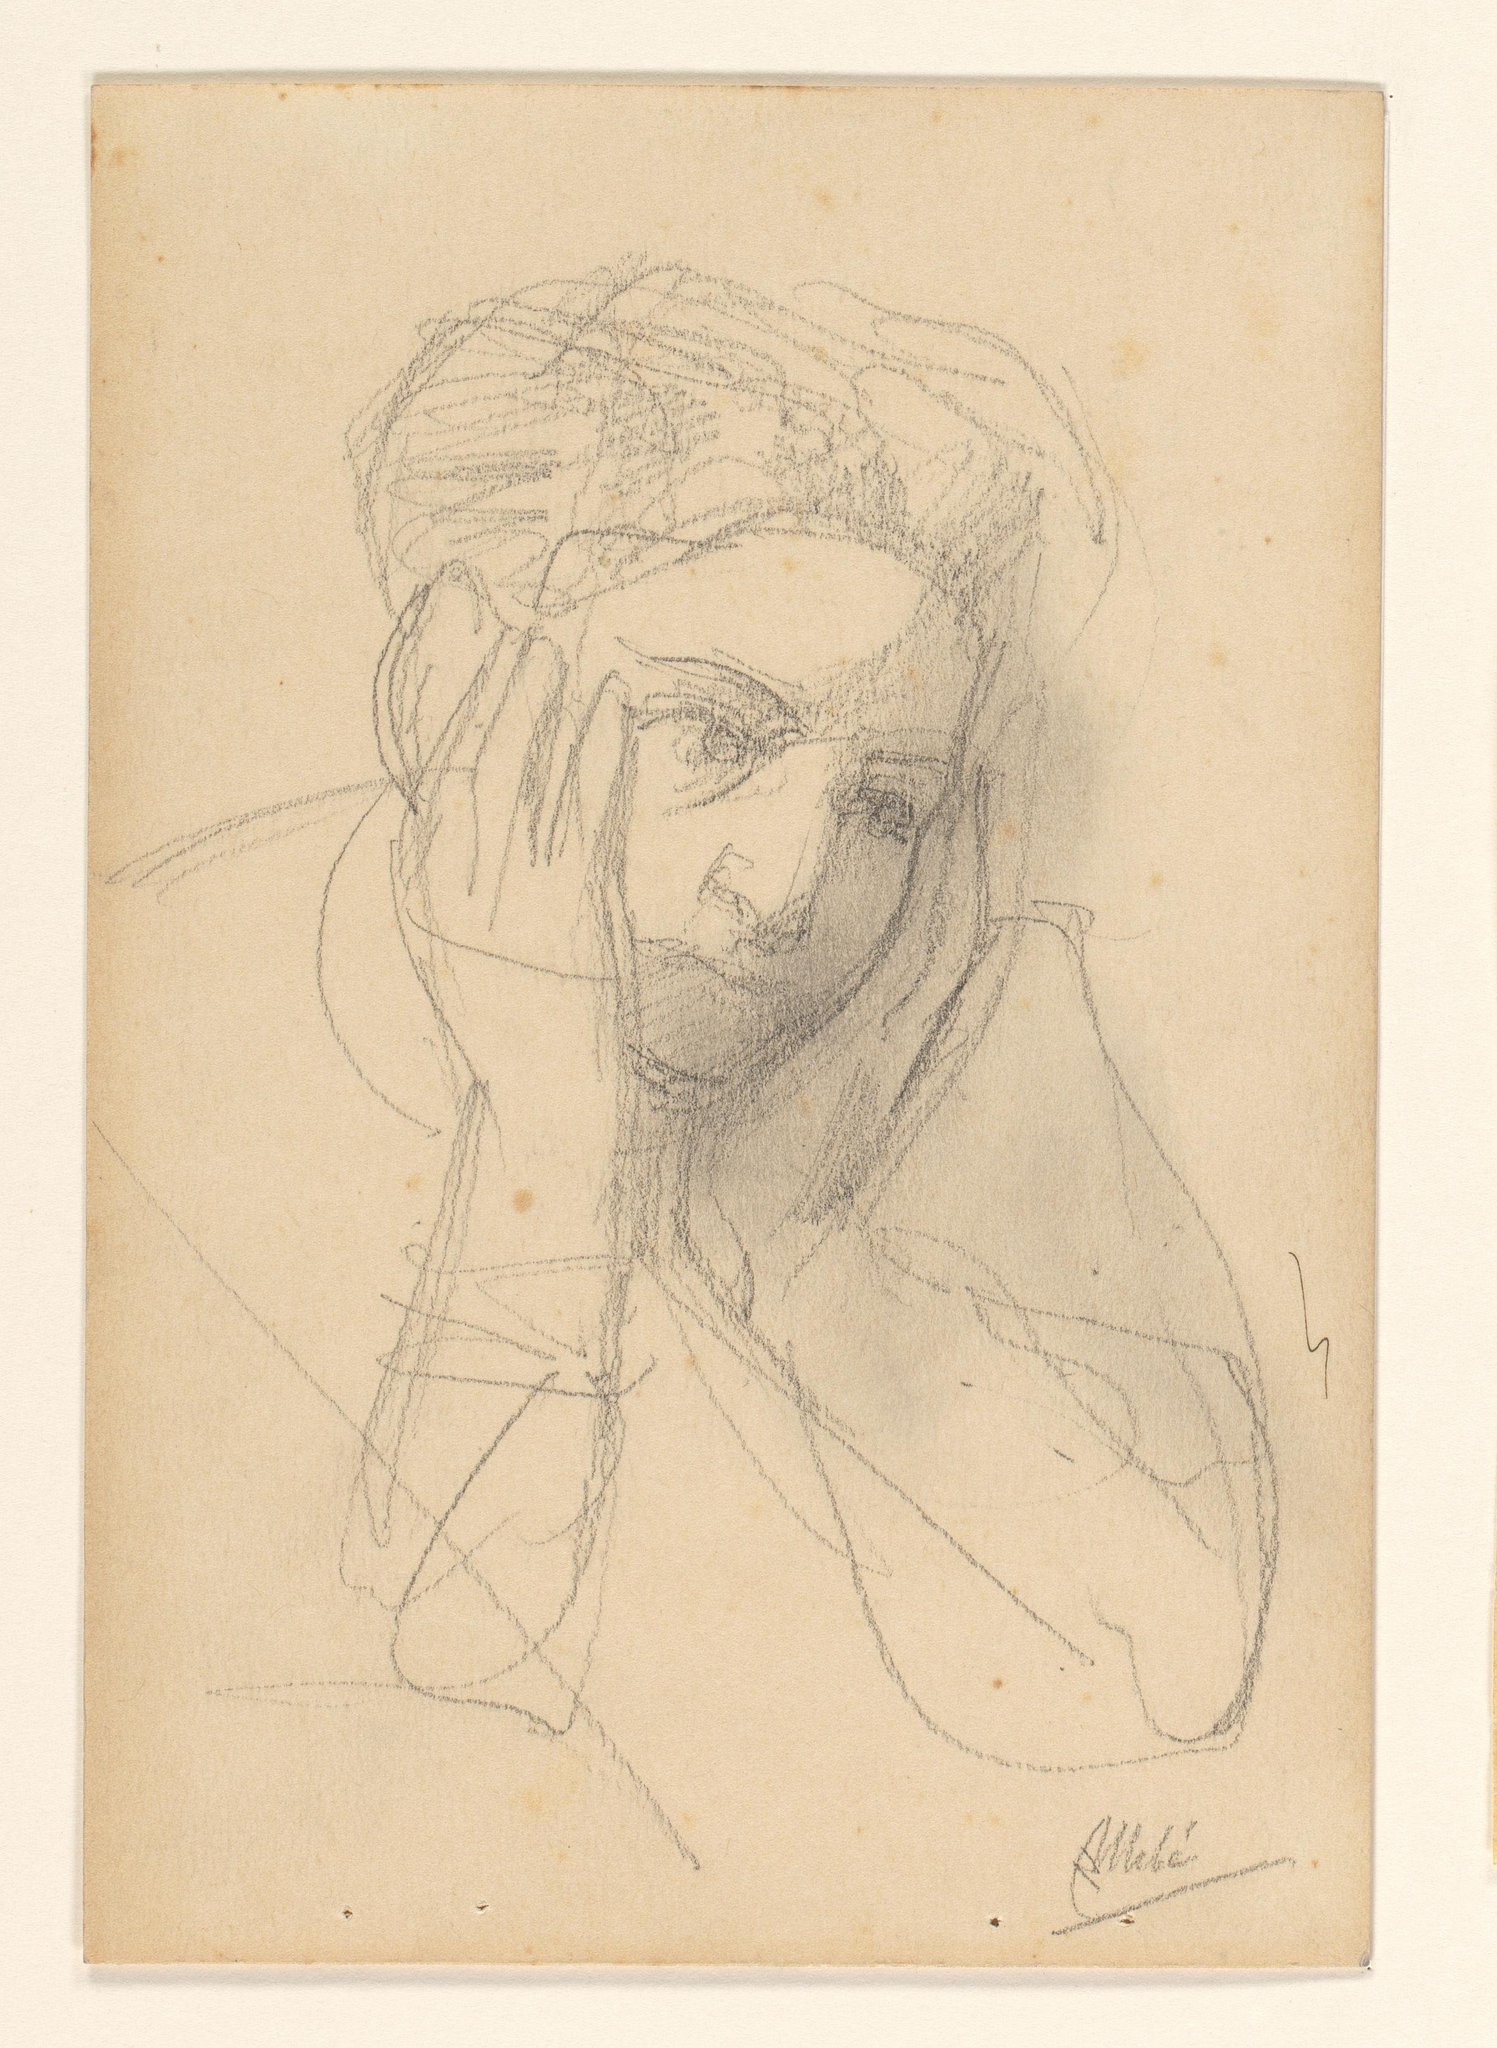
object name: drawing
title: Oude zittende vrouw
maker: august allebé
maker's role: draughtsman, print maker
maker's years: 1838-1927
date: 1848-1927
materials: pencil, paper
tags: sitting figure - aa - female human figure